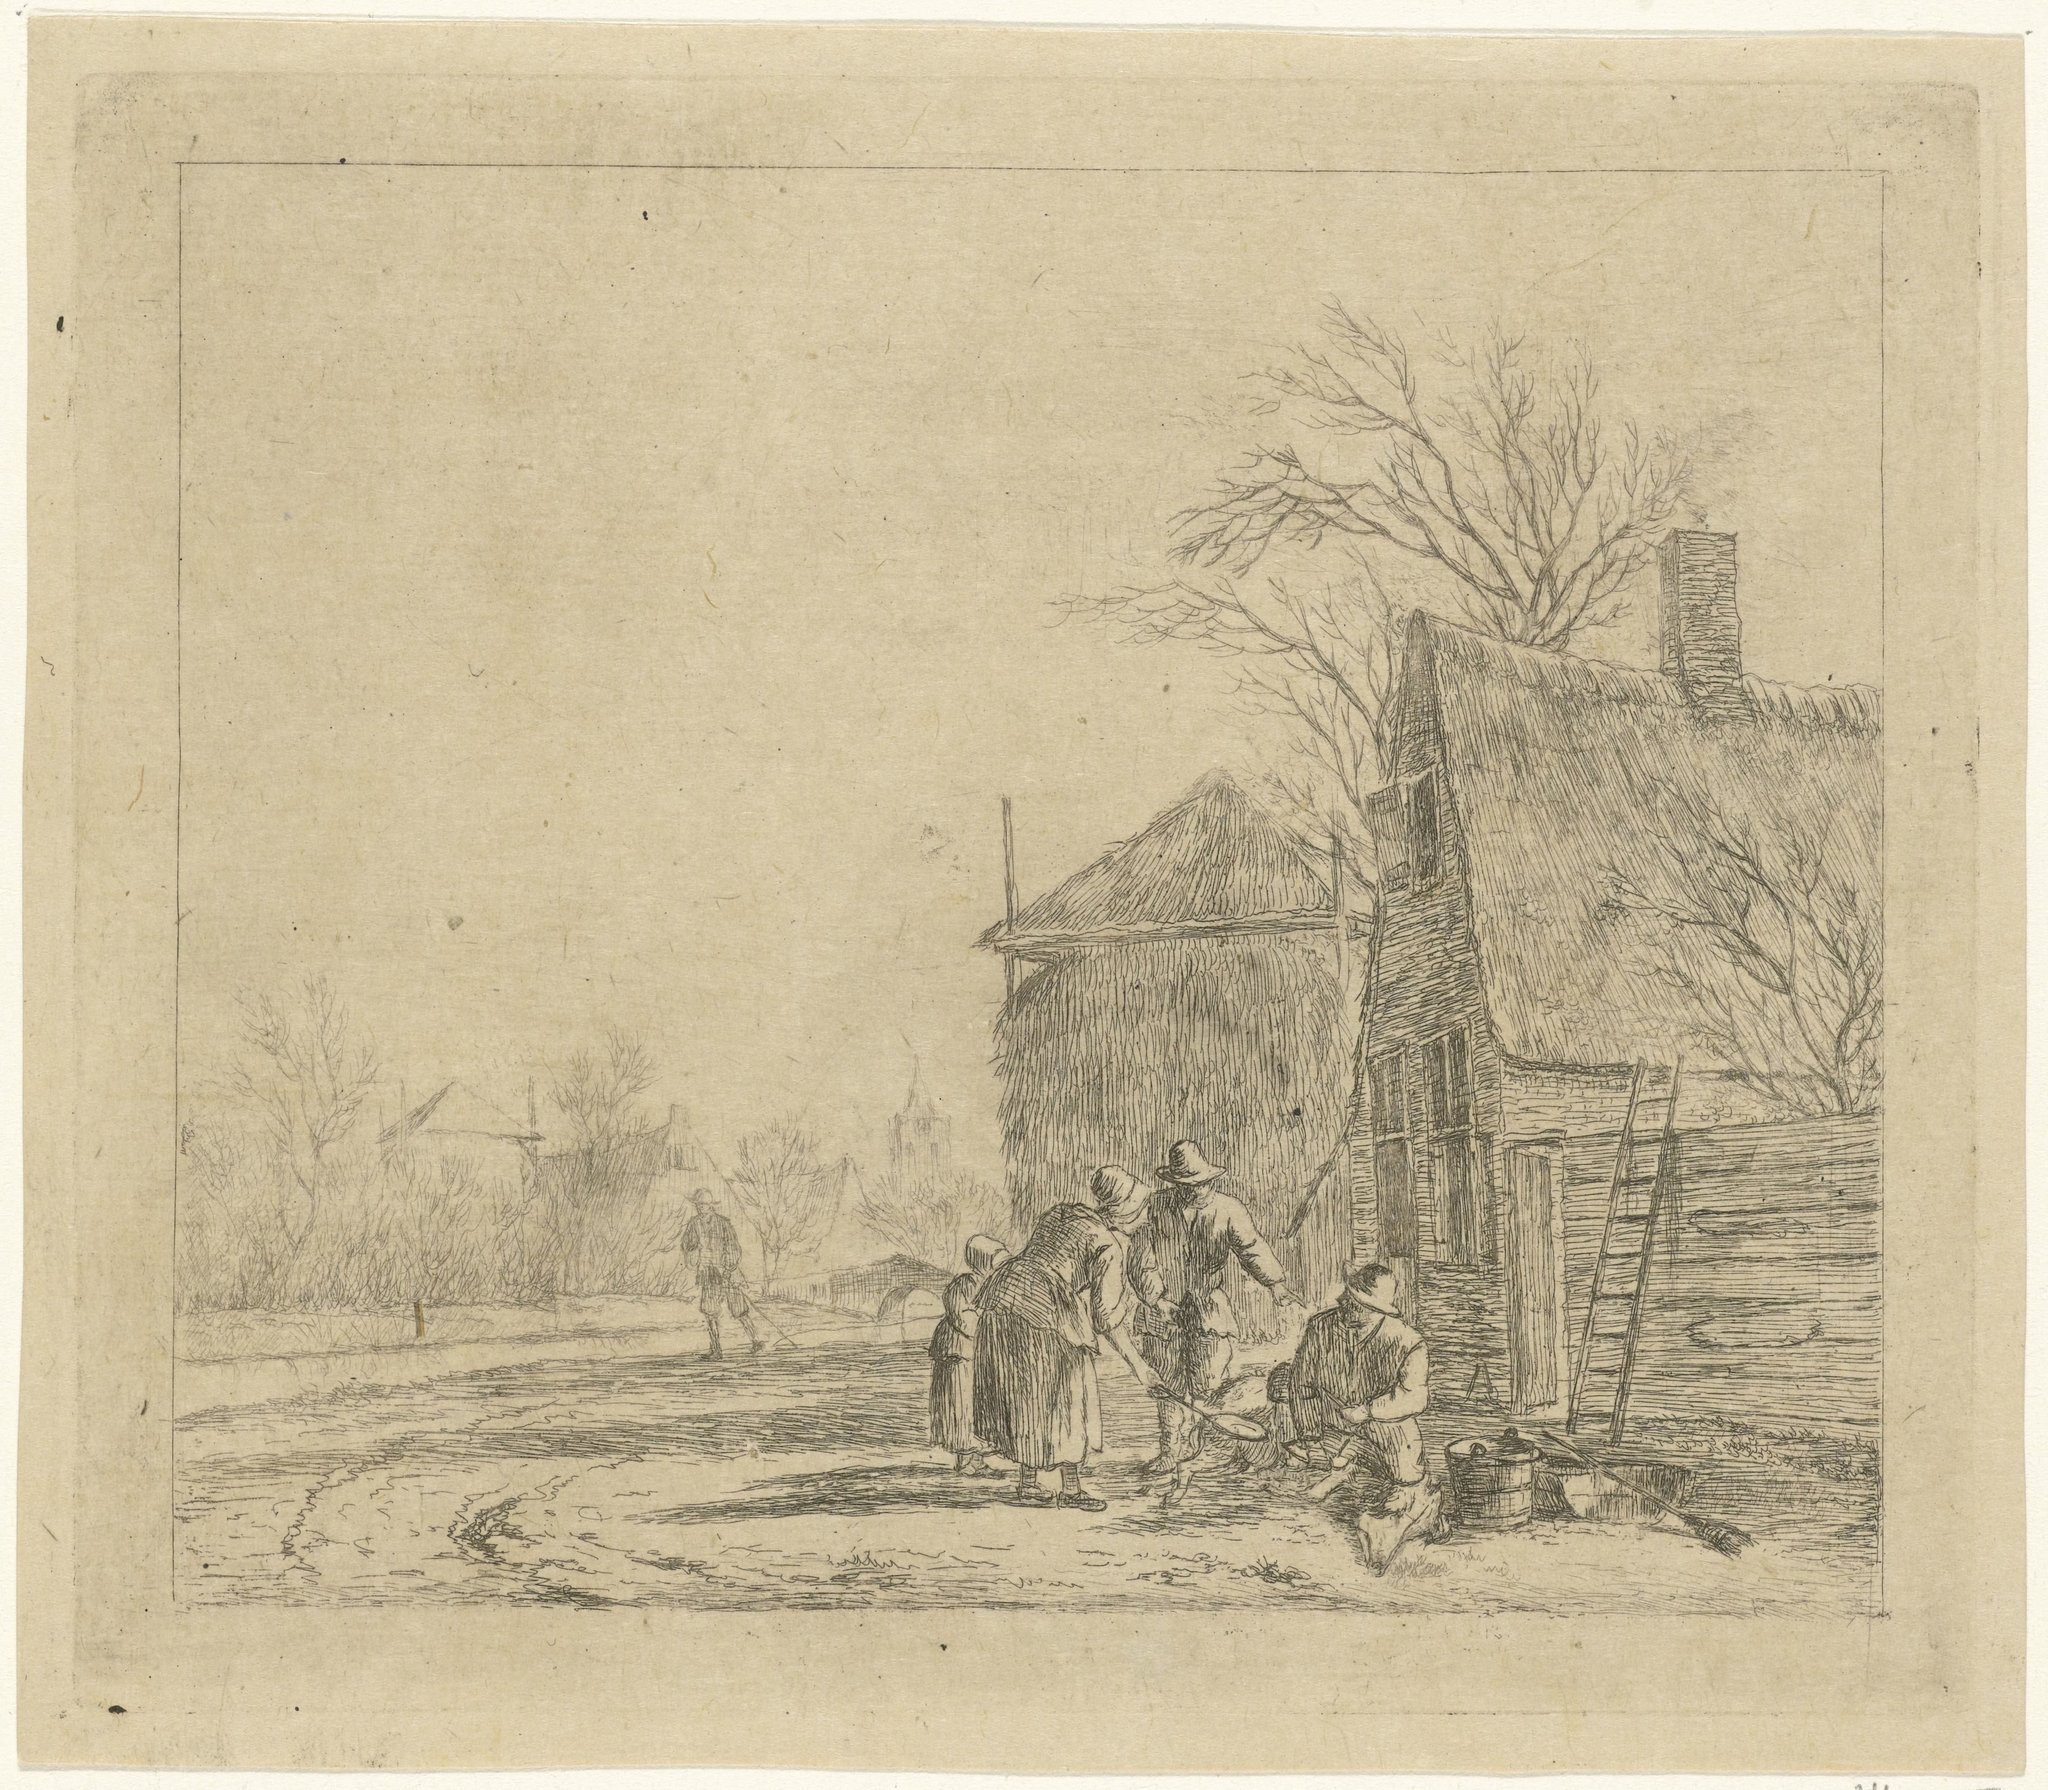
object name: print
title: De gecouleurde Teekeningen van de 12 Maanden (...)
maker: johannes janson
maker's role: draughtsman, painter, print maker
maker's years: 1729-1784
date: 1783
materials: paper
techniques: etching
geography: leiden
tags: landscape symbolizing november, hay-stack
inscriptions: collector's mark: Lugt 240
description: Landschap met rechts een boerderij en een hooischuur. Voor de boerderij een groep van twee vrouwen en twee mannen, van wie één een varken open snijdt. Bomen bij boerderij en hooischuur zijn aangepast ten opzichte van vorige staten. Links op een pad een wandelende man. Op de achtergrond een hooischuur en kerktoren. Vóór de lucht. Twaalfde prent uit een serie van dertien met maanden.